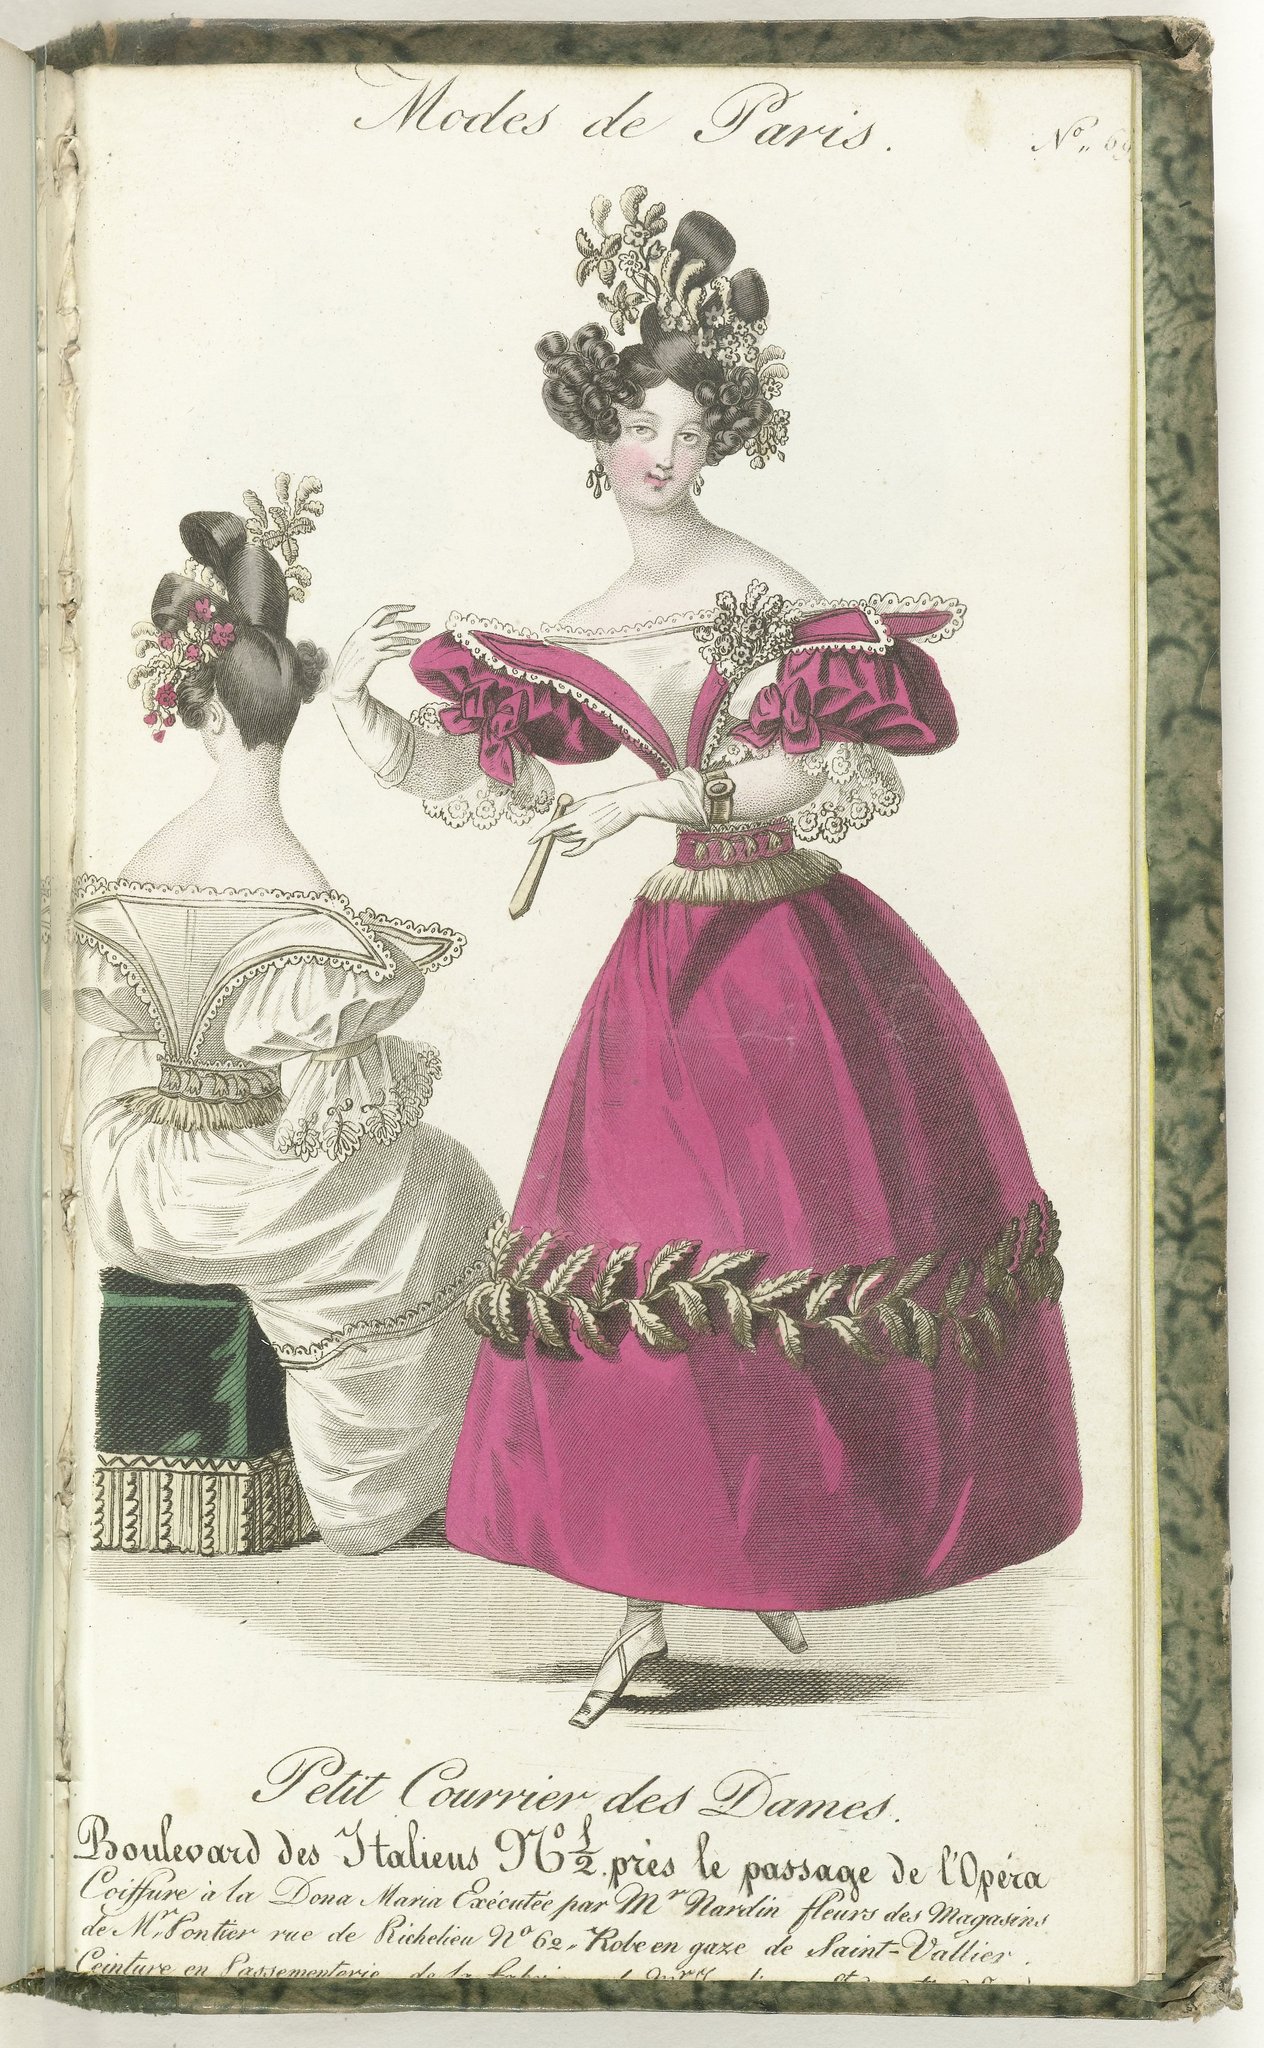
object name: fashion print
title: Petit Courrier des Dames, 5 février 1830, No. 699 : Coiffure à la Dona Maria...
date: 1830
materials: paper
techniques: engraving, hand coloring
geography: paris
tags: corsage (+ women's clothes), flowers, gloves, mittens (long gloves) (+ women's clothes), styles of hairdress - aa - ~ women, fashion plates, dress, gown (+ women's clothes), fan (+ women's clothes), bracelet, wristlet (+ women's clothes), belt, girdle, waistband (+ women's clothes)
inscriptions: title: ‘Modes de Paris.’, address: ‘Boulevard des Italiens No.2 près le passage de l'Opèra.’, caption: ‘Coiffure à la Dona Maria Exécutée par M.r Nardin fleurs des Magasins de M.r Pontier rue de Richelieu No 62, Robe en gaze de Saint-Vallier. Ceinture en Passementerie (...ontbreekt...)’, title: ‘Petit Courrier des Dames.’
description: Staande vrouw gekleed in een japon van 'gaze de Saint-Vallier'. Ceintuur van passementerie. 'Coeffure à la Dona Maria' uitgevoerd door Nardin. Bloemen uit de winkels van Pontier. Zittende figuur, op de rug gezien, gekleed in eenzelfde japon. Prent uit het modetijdschrift Petit Courrier des Dames (1821-1868). Ingebonden (met enkele pag. Le Journal des Dames et des Modes). 15 Januari 1827 t/m 20 maart 1830. Incompleet.